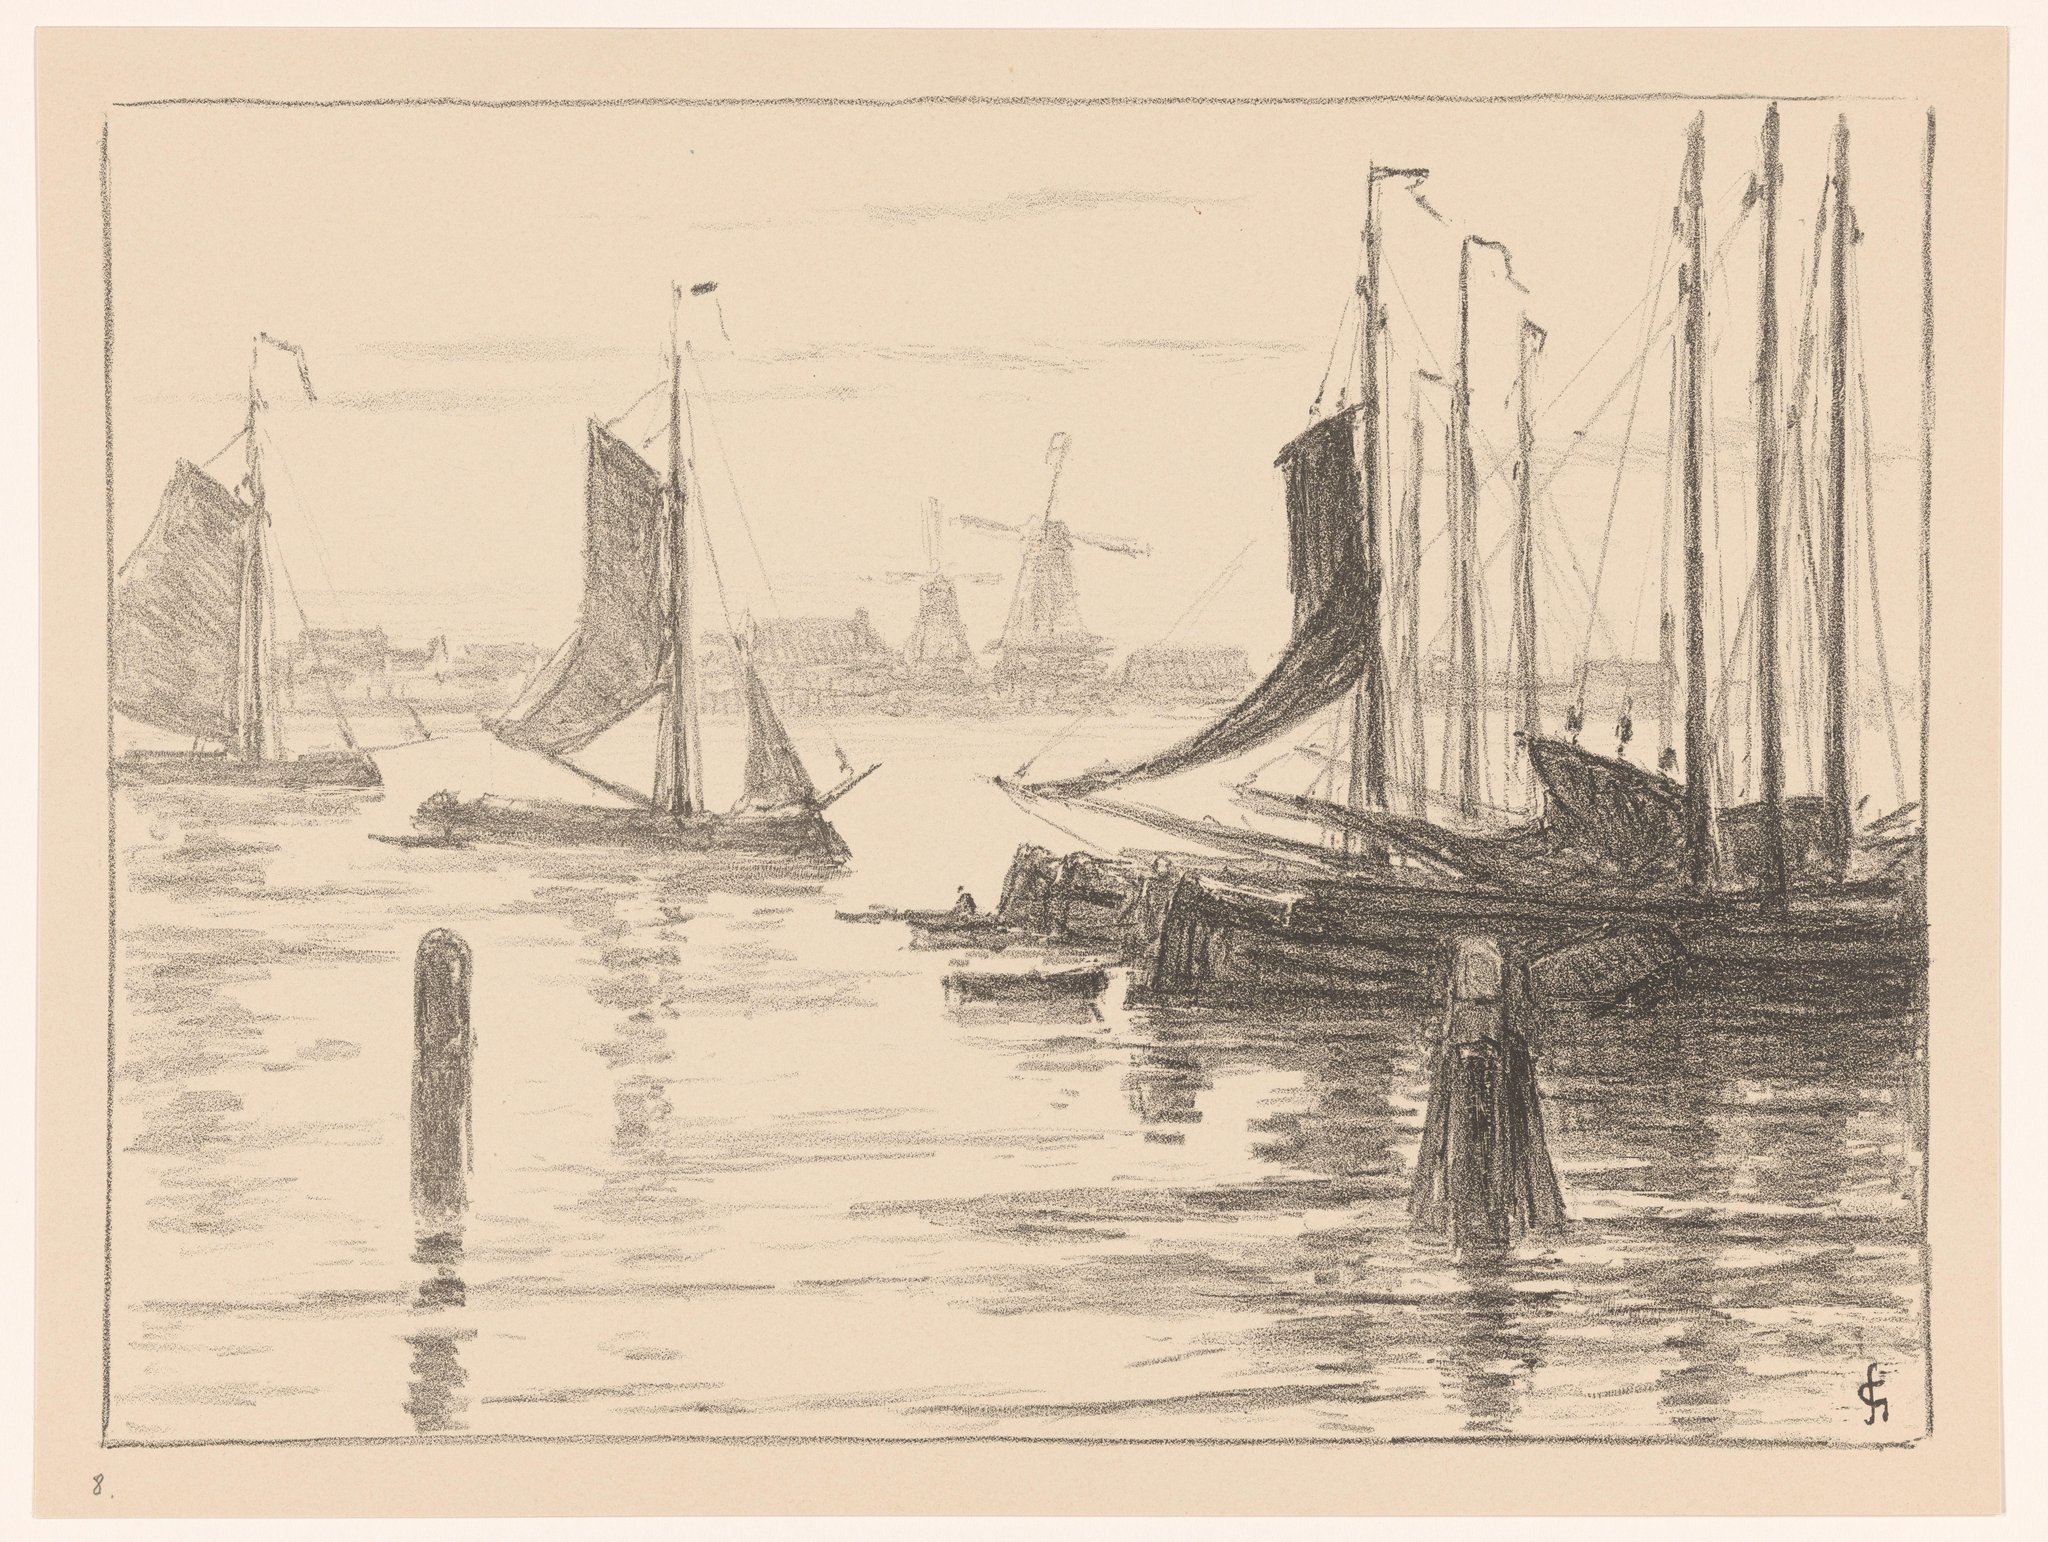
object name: print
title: Vissershaven in Dordrecht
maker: carel nicolaas storm van s-gravesande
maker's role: draughtsman, print maker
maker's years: 1841-1924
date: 1851-1902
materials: paper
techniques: lithograph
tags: harbour, windmill in landscape, dordrecht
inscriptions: collector's mark: Lugt 2228, number: ‘8’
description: Mogelijk vermeld in: Storm van 's-Gravesande, Charles. Catalogue des eaux-fortes et lithographies. New York: s.n., 1903, of in een onbekende latere uitgave van het manuscript. Vermoedelijk vermeld als catalogusnummer 8.